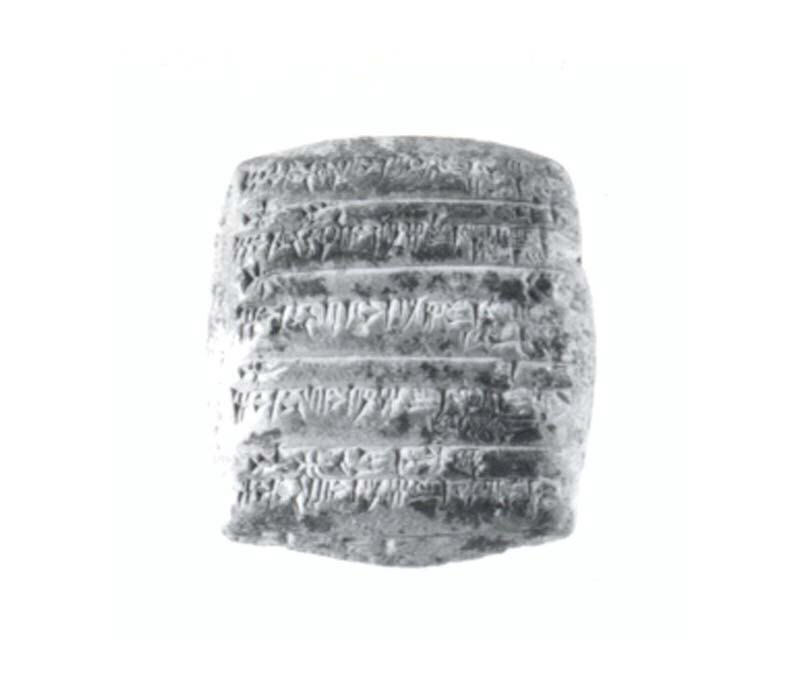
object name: cuneiform tablet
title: Cuneiform tablet: messenger tablet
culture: neo-sumerian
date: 2034 BCE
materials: clay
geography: mesopotamia